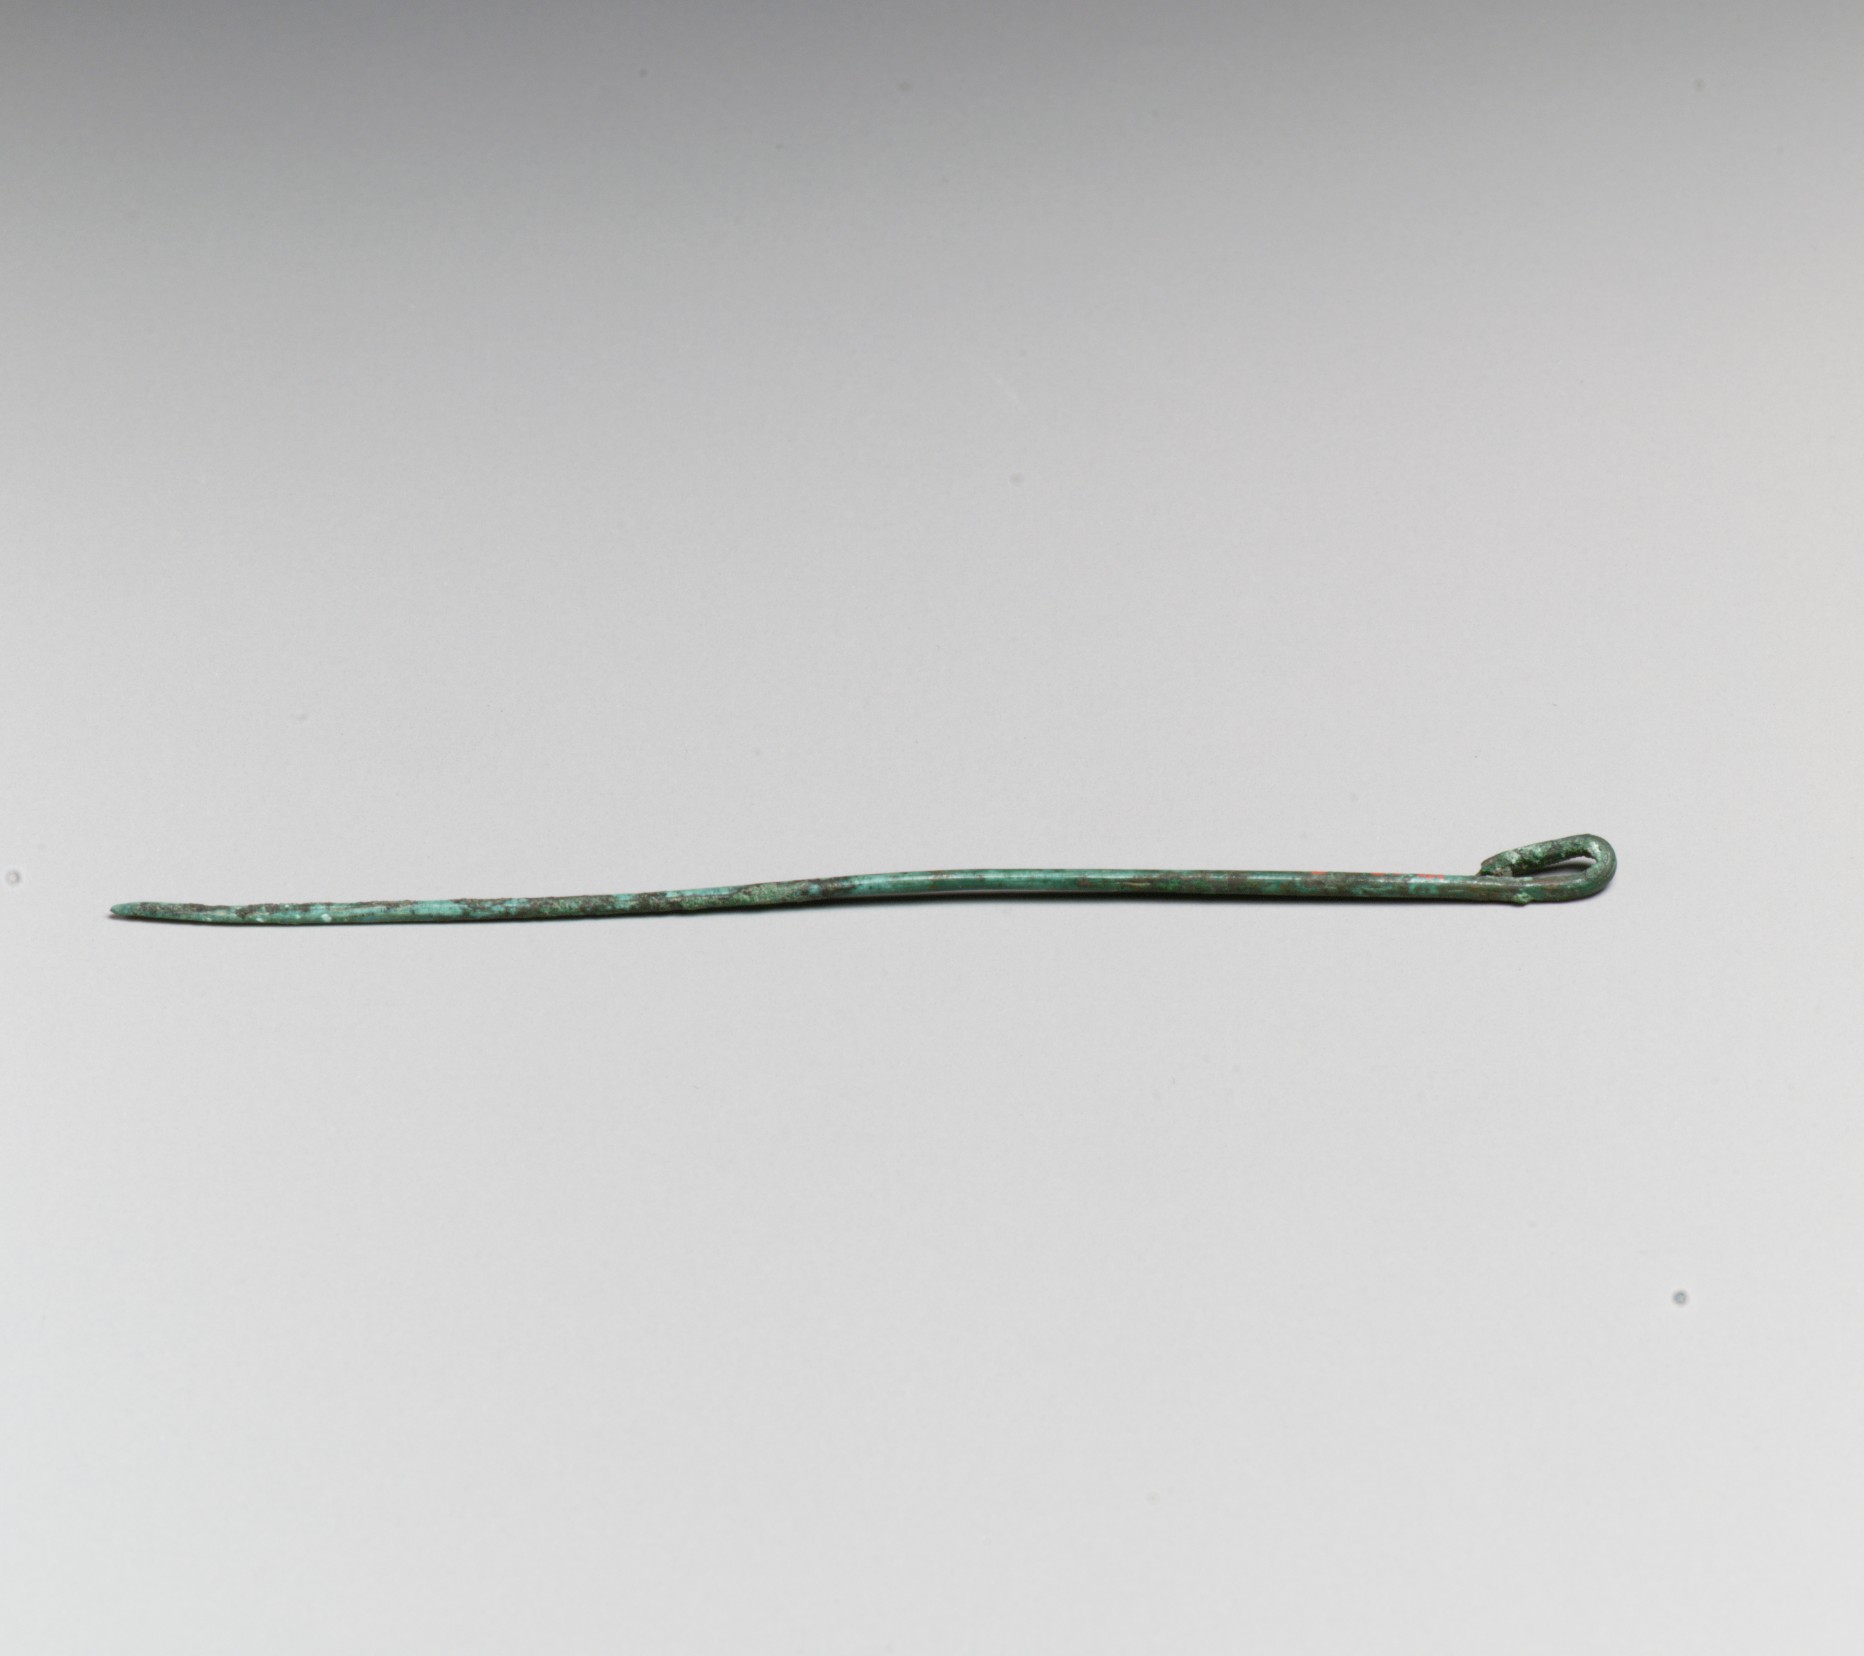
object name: pin with hooked head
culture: roman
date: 670 BCE-330 CE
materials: bronze